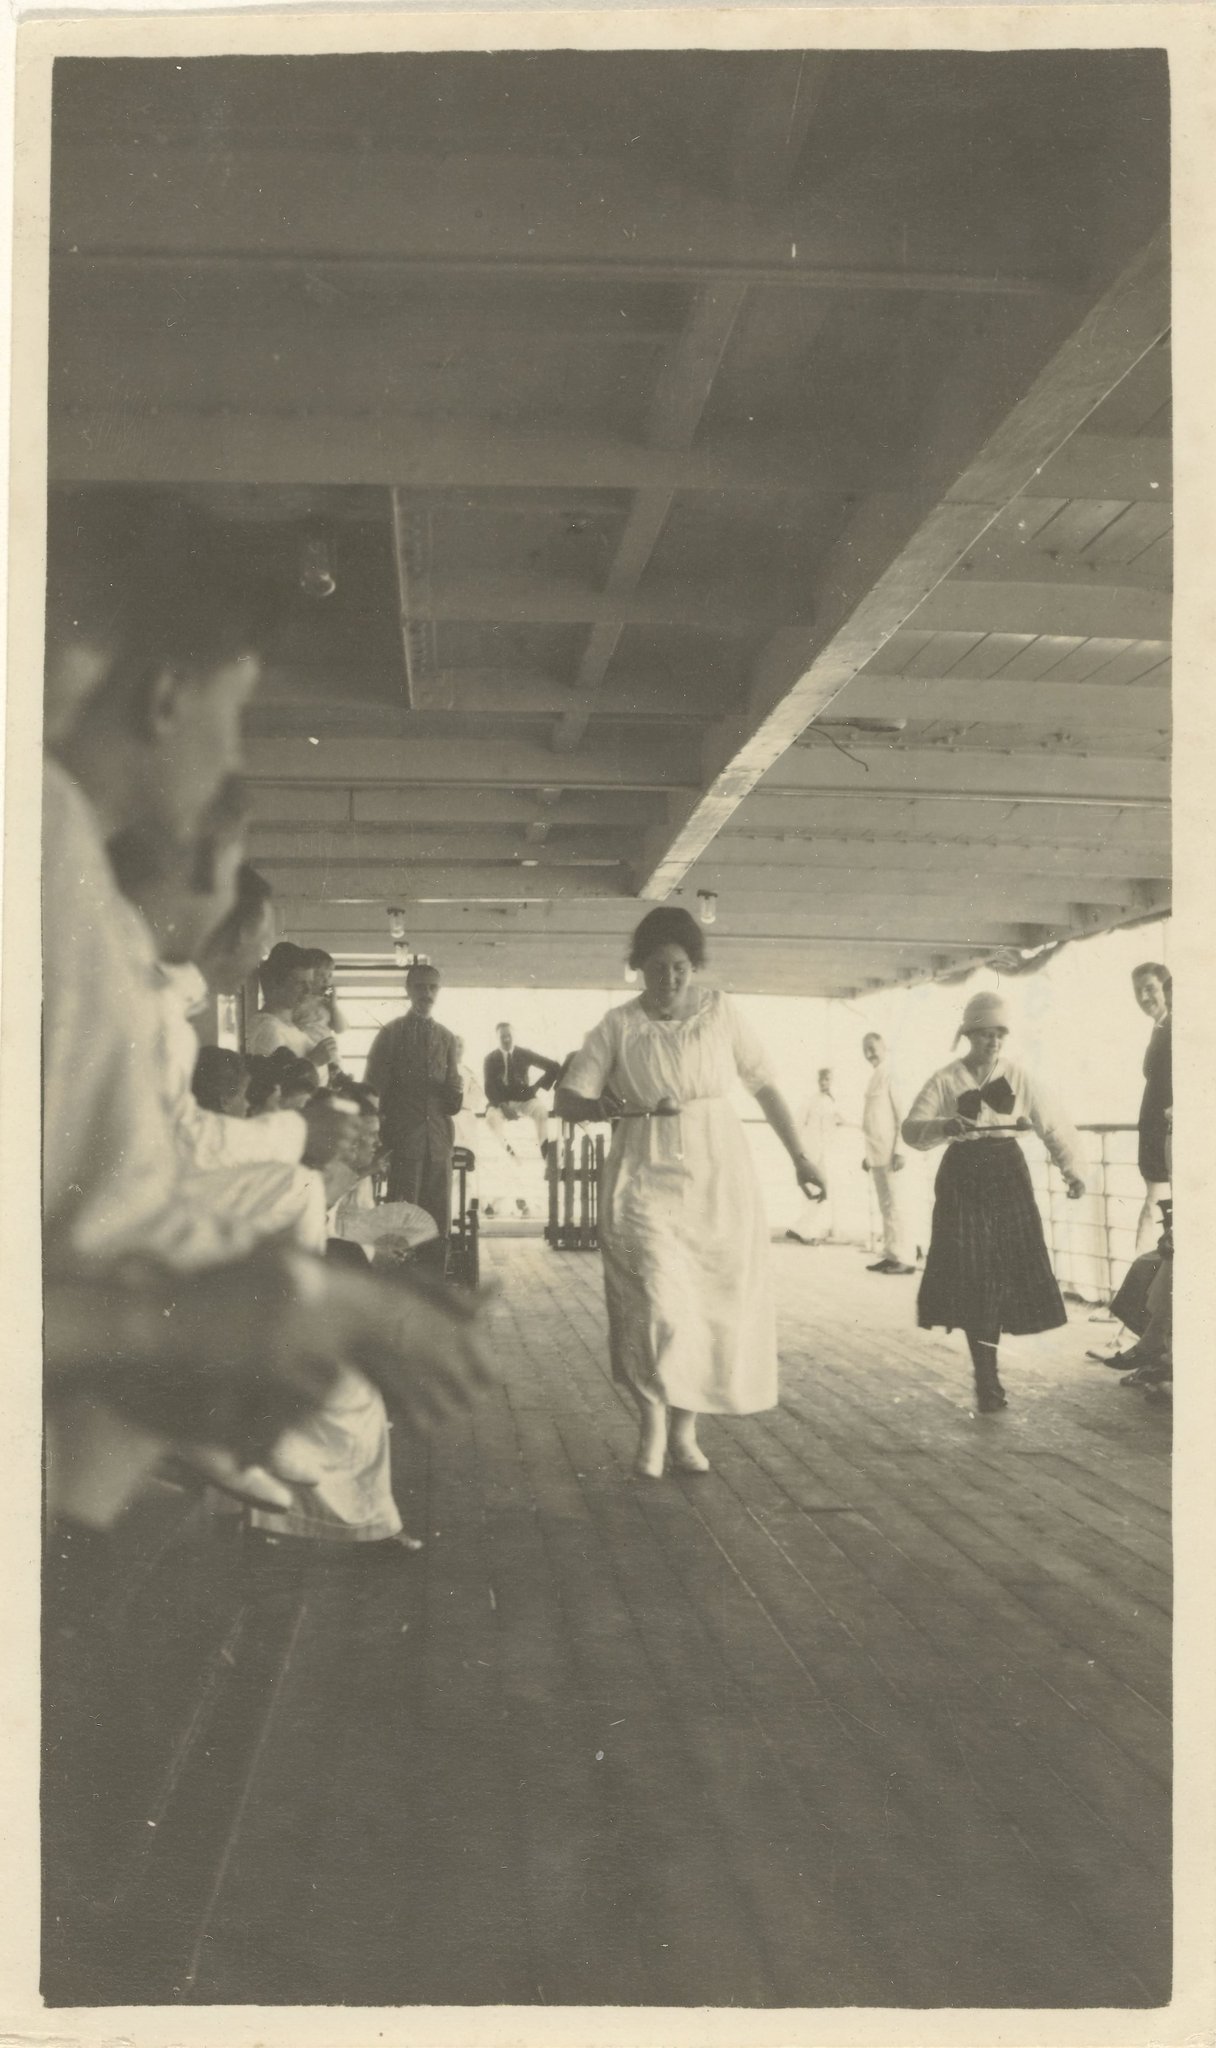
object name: photograph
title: Tine Vermeulen tijdens het spel eieren lopen aan boord van een schip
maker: Anonymous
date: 1920-1940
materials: photographic support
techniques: gelatin silver print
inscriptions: inscription: ‘a.b. Sindow April '19’